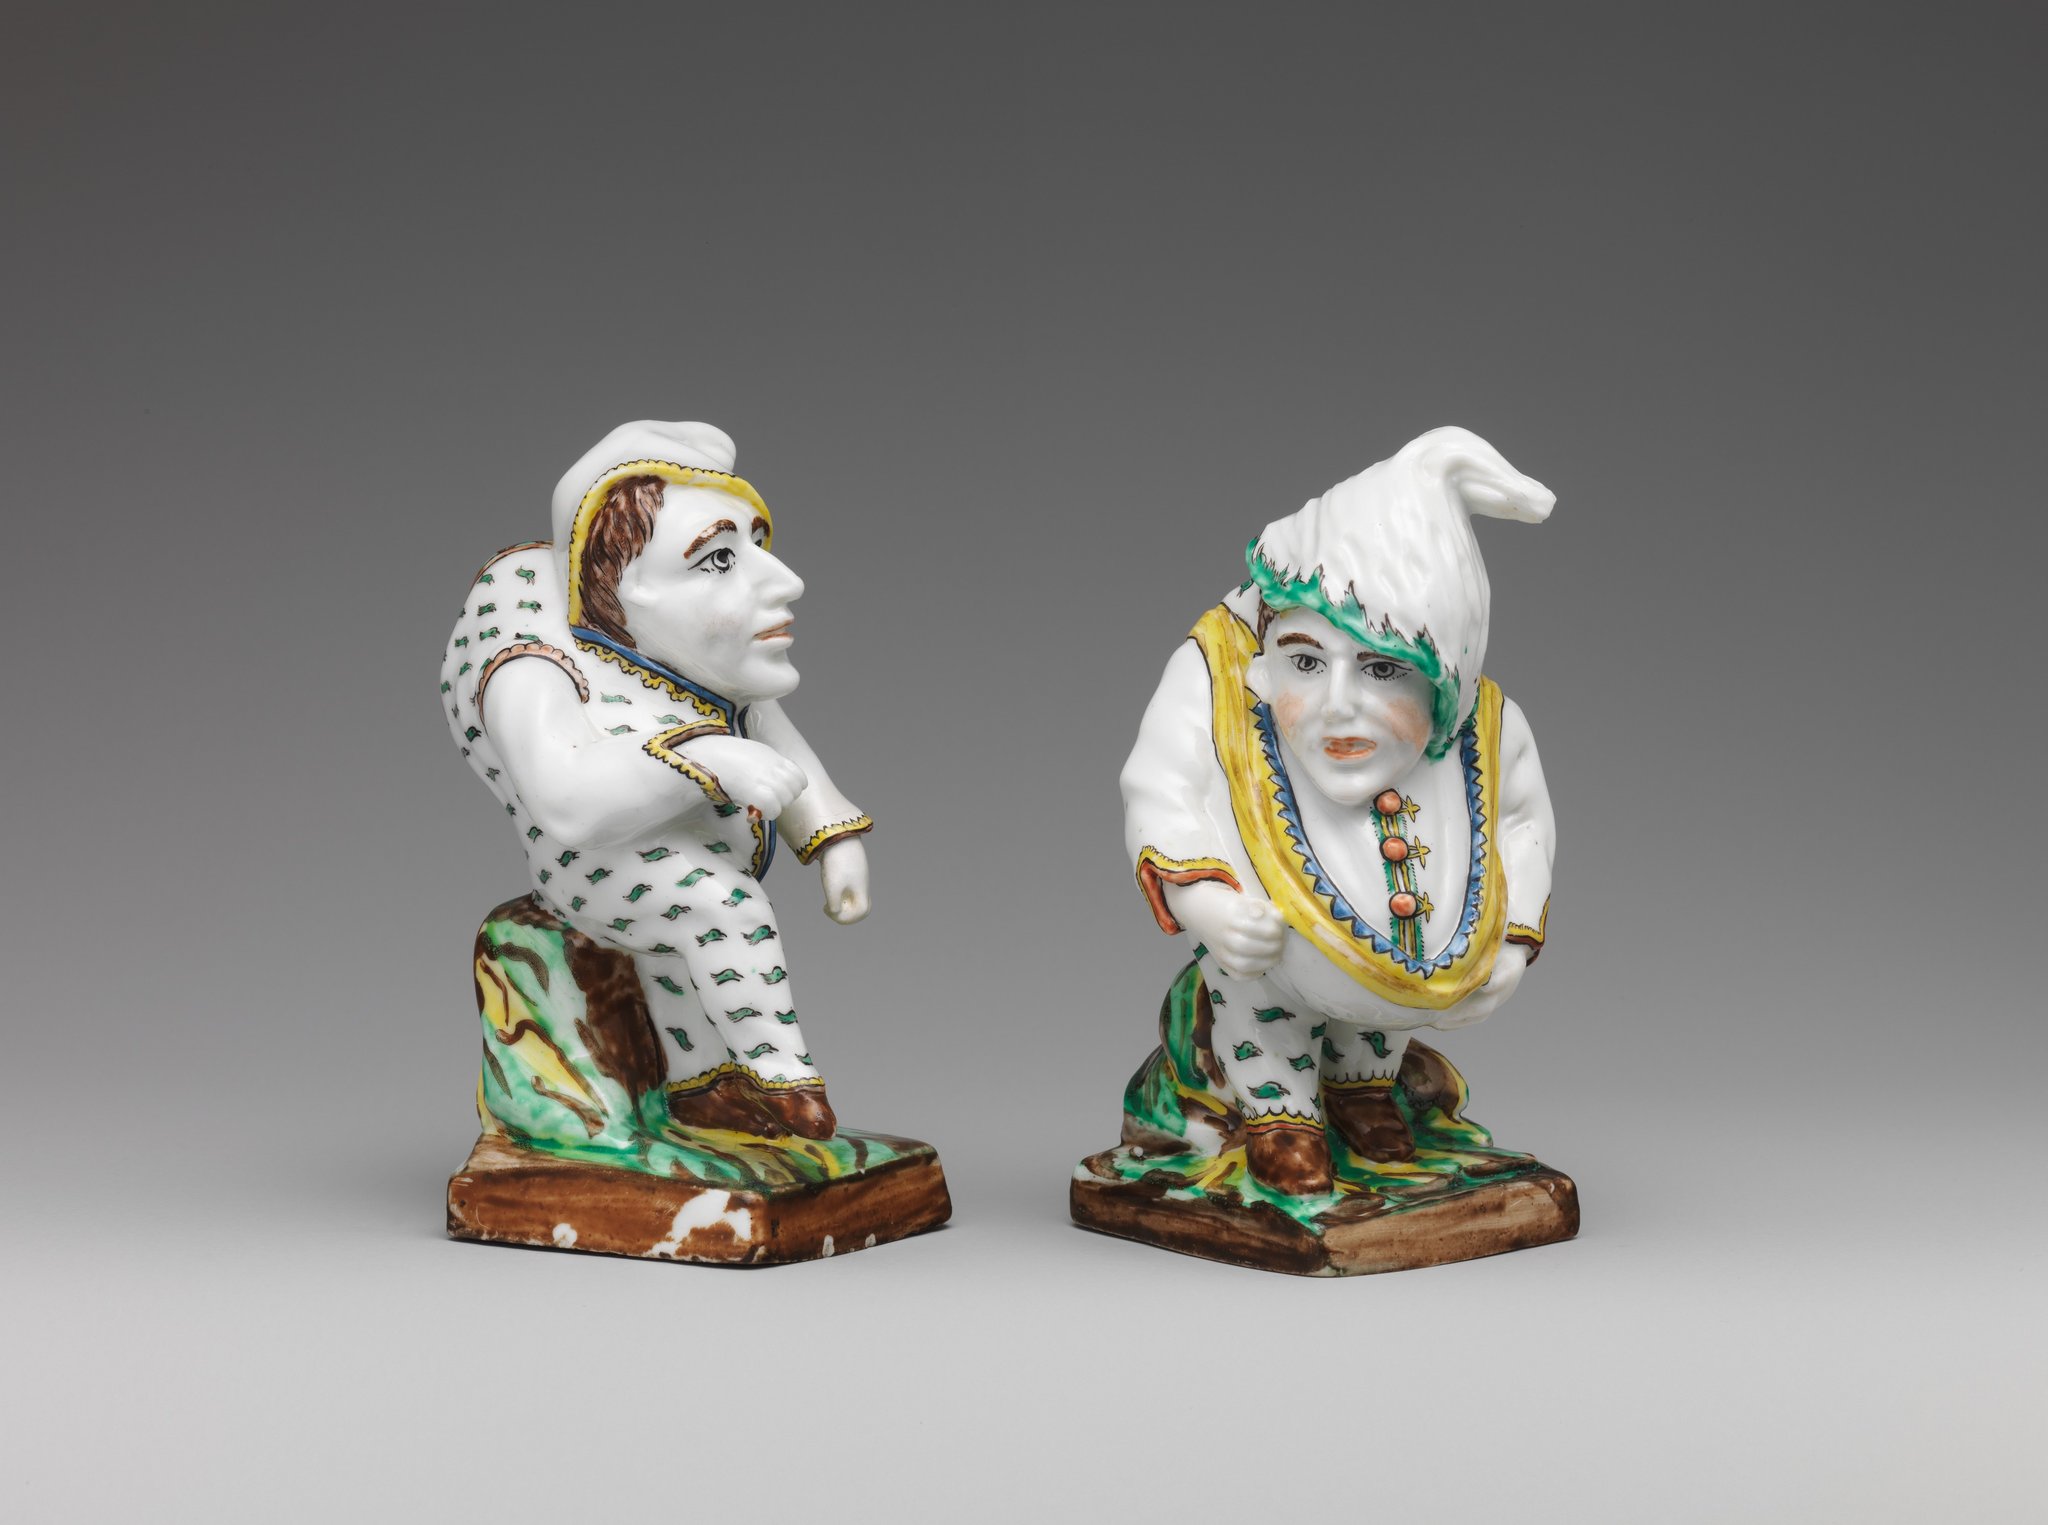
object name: figure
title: Dwarf (one of a pair)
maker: villeroy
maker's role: manufactory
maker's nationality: french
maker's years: 1734-1748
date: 1740-1745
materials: enamel, soft paste porcelain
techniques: polychrome, glazing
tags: men